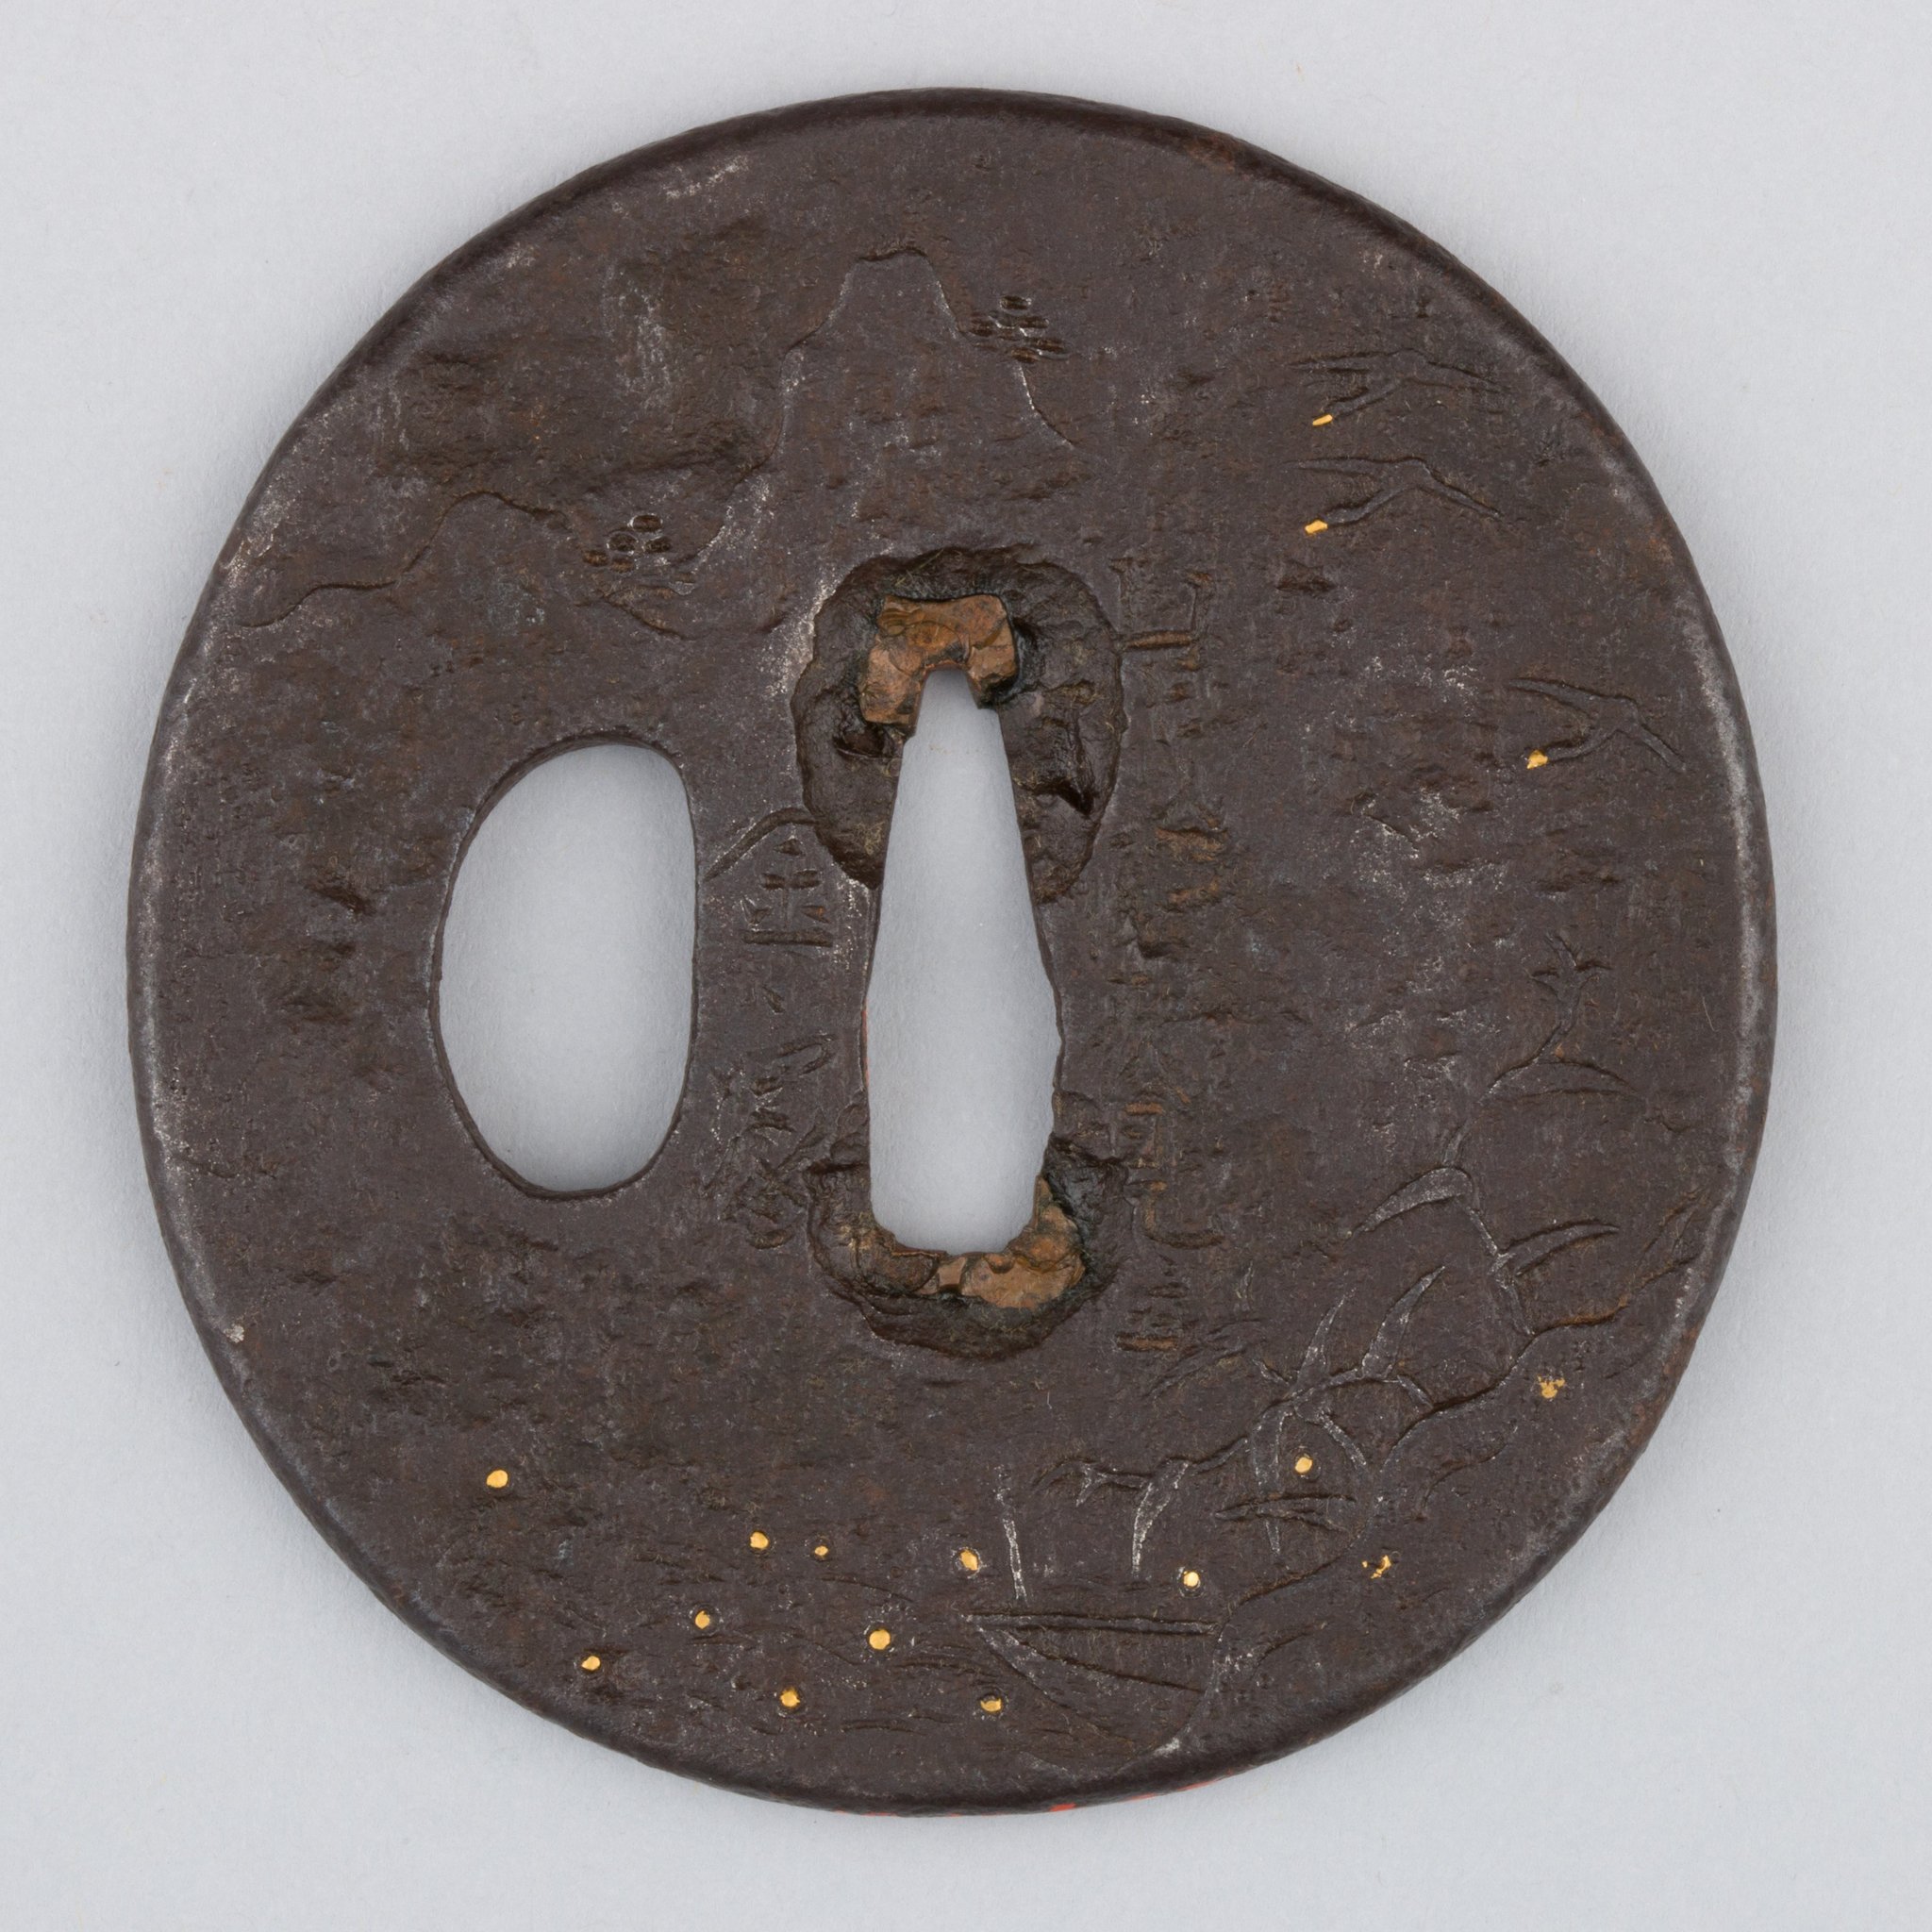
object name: sword guard tsuba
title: Sword Guard (Tsuba)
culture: japanese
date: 1615-1868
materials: copper, iron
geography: japan